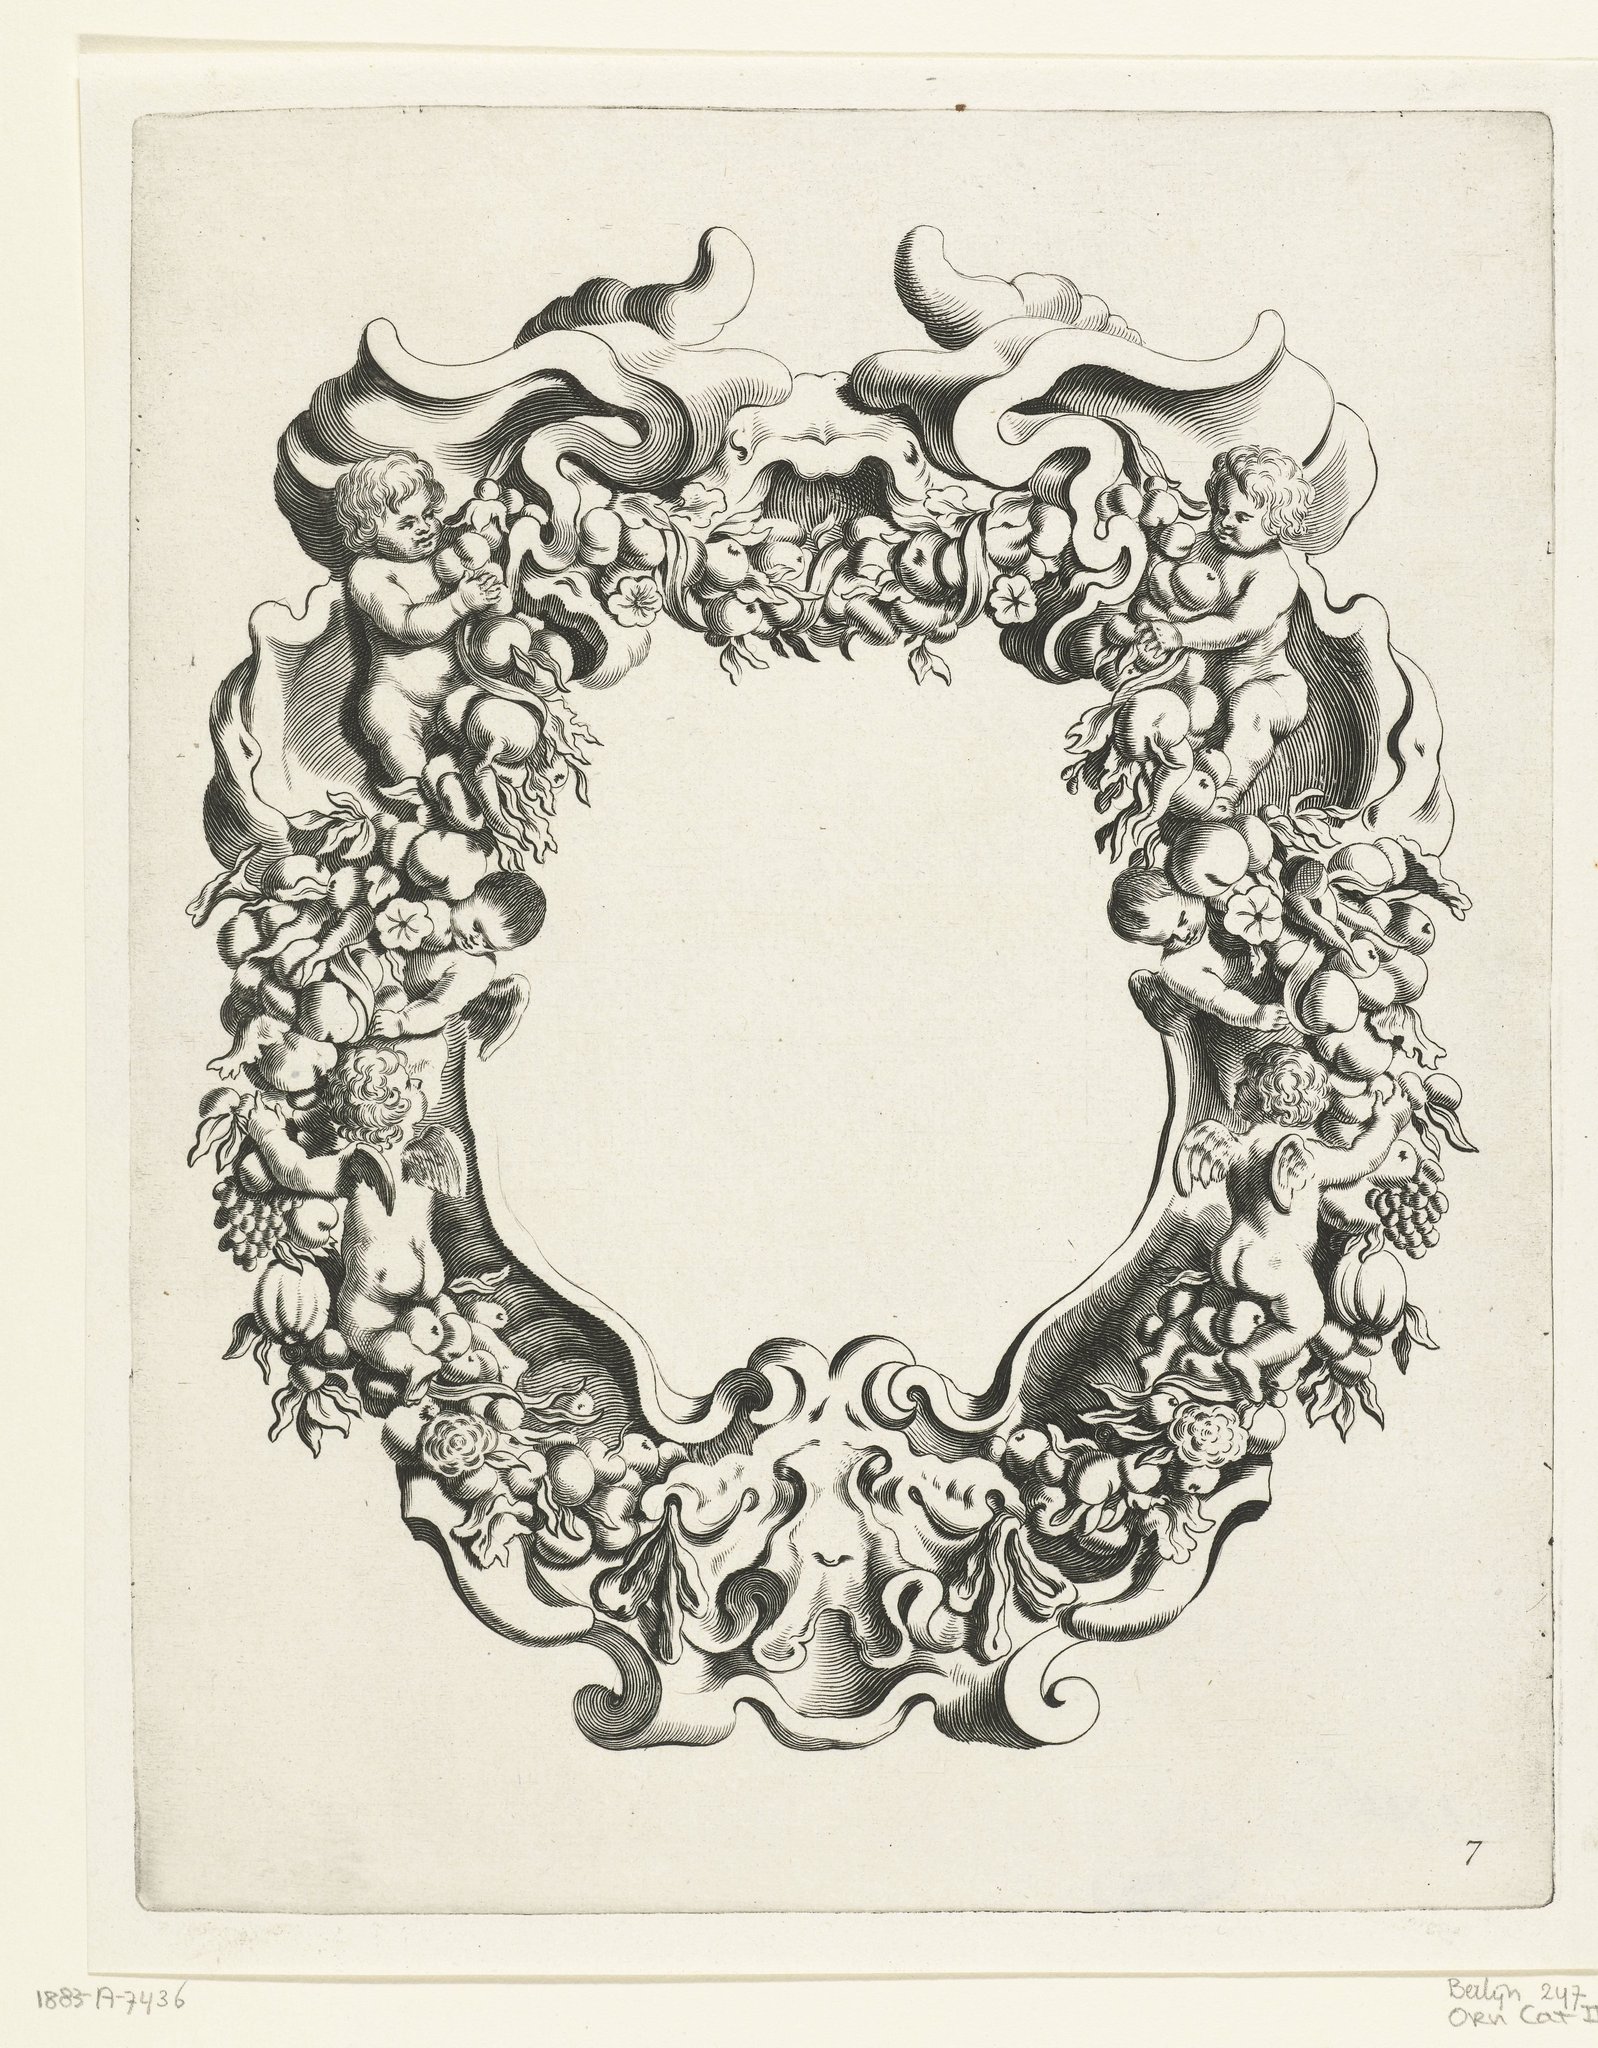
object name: print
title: Cartouche met kwabornament met twee putti en vier engeltjes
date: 1640-1655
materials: paper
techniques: engraving, etching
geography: amsterdam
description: Gedecoreerd met een guirlande van bloemen en fruit. Boven- en onderaan een masker.